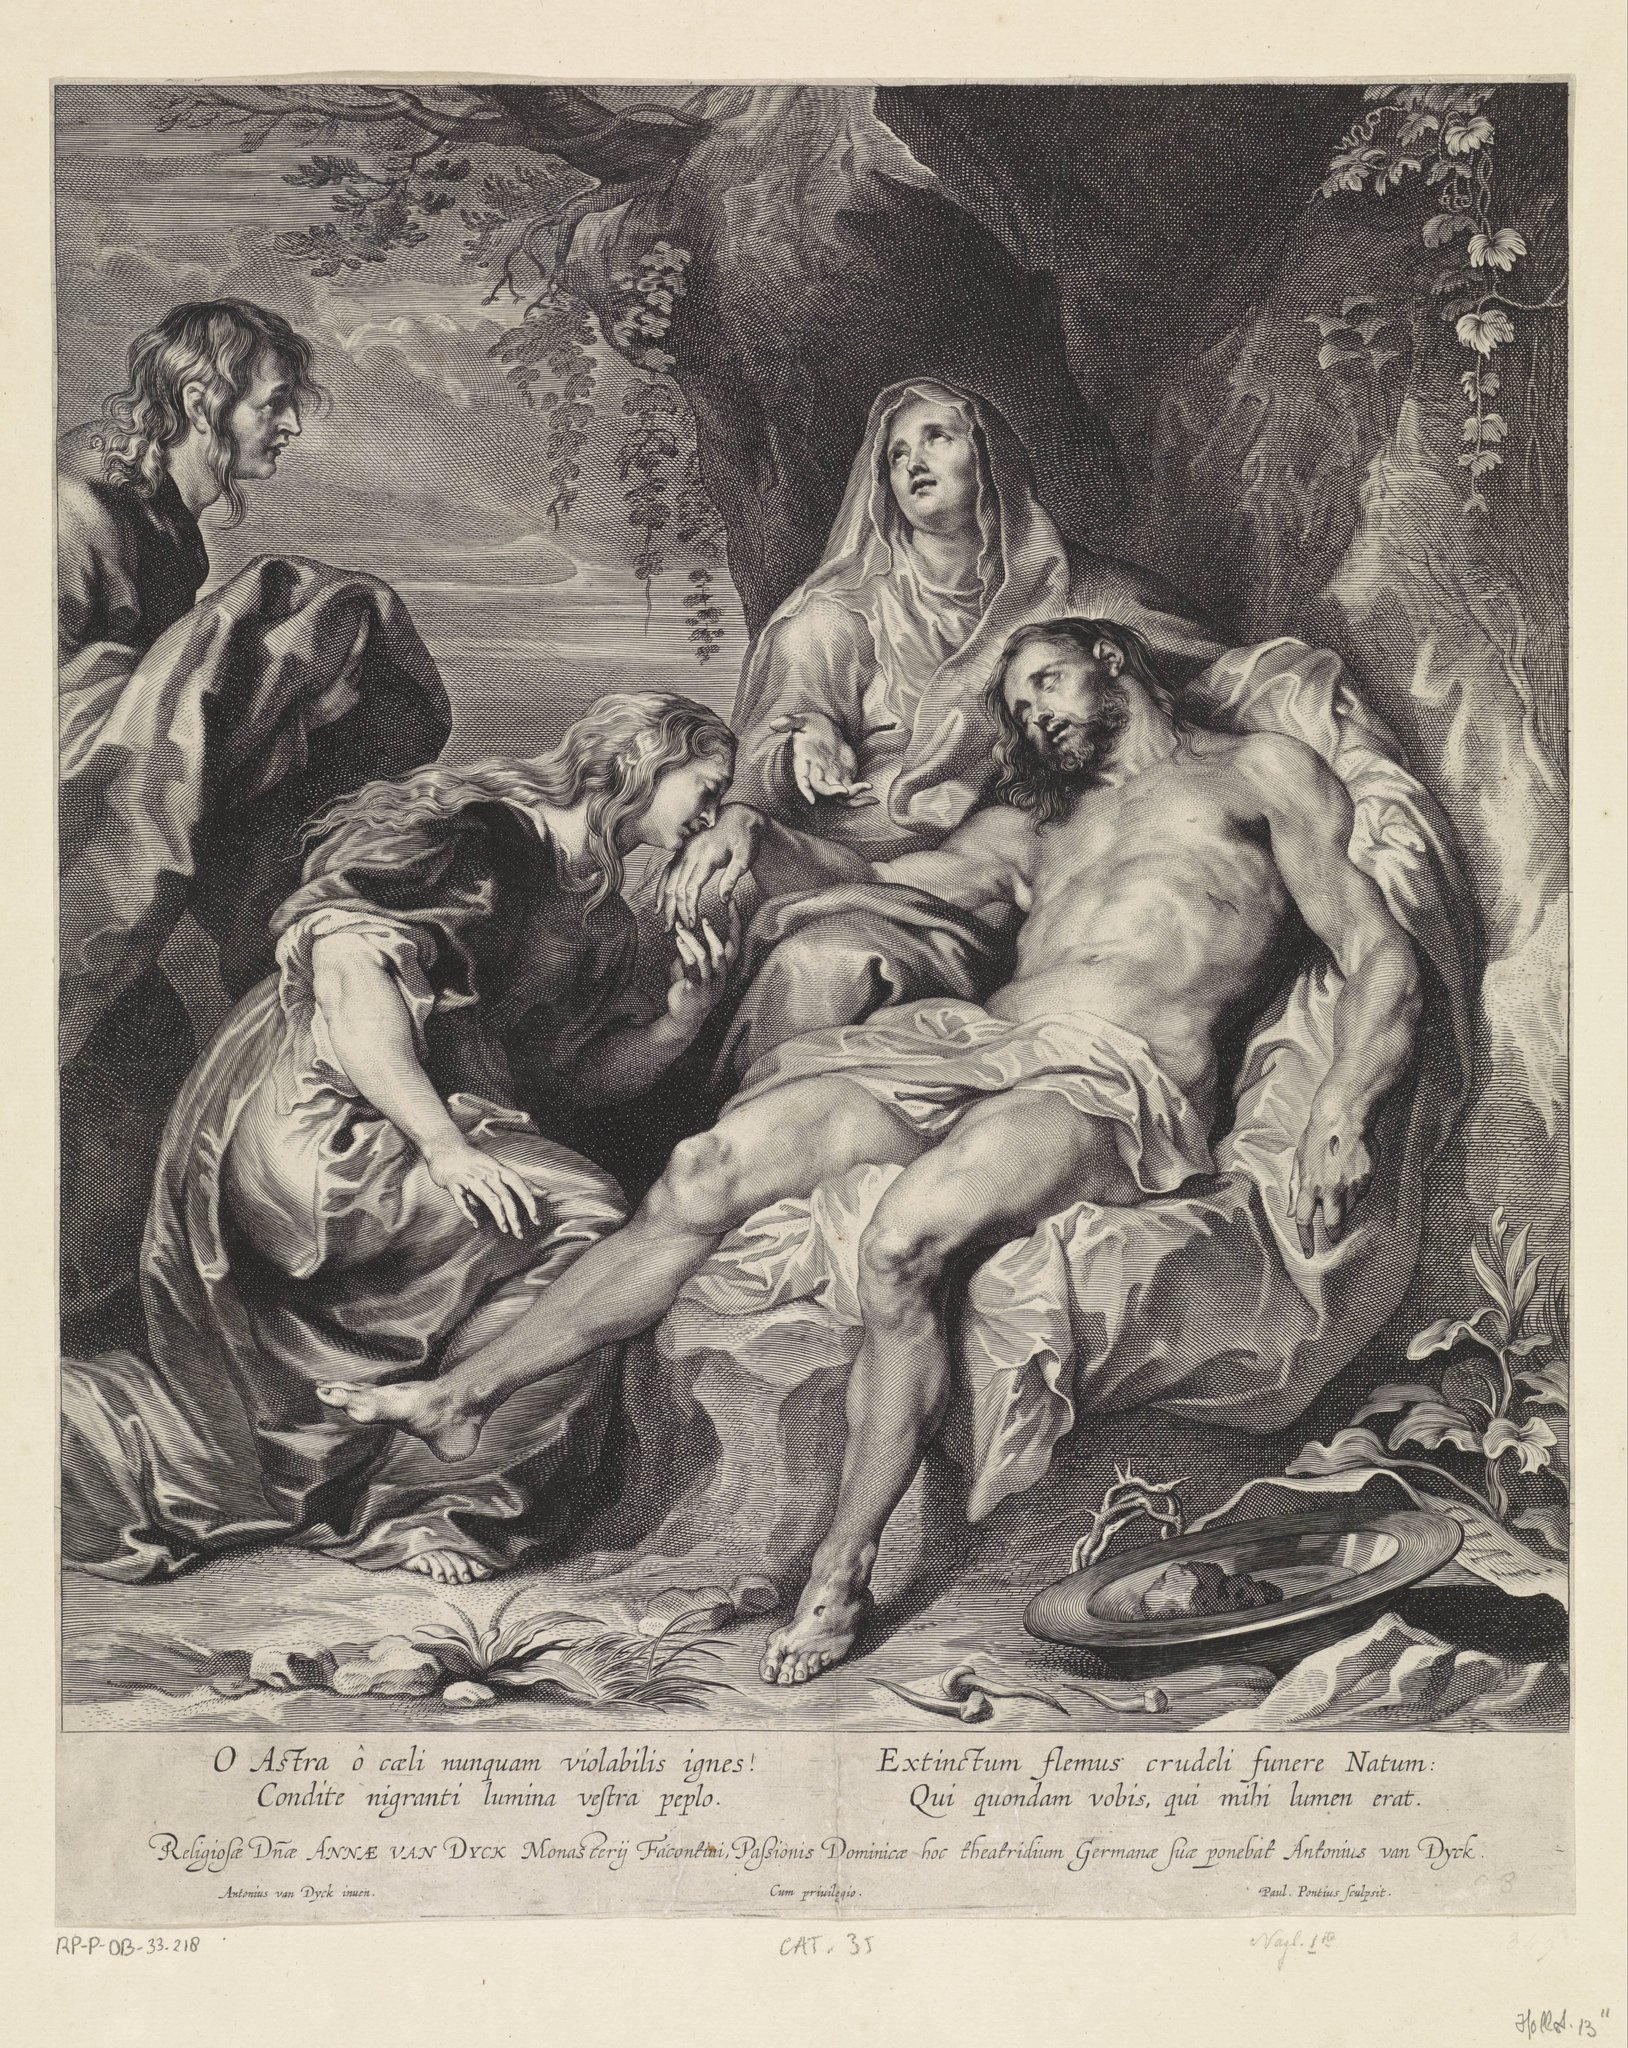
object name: print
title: Bewening van Christus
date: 1628-1657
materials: paper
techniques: engraving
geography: antwerp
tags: single instruments of the passion, lamentation over the dead christ by his relatives and friends (christ usually without crown of thorns)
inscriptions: collector's mark: Lugt 240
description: Maria, Maria Magdalena en Johannes de Evangelist treuren bij het lichaam van Christus. Aan Christus' voeten liggen de doornenkroon en de spijkers. In de marge een vierregelig onderschrift, in twee kolommen, in het Latijn. Daaronder een opdracht in het Latijn.